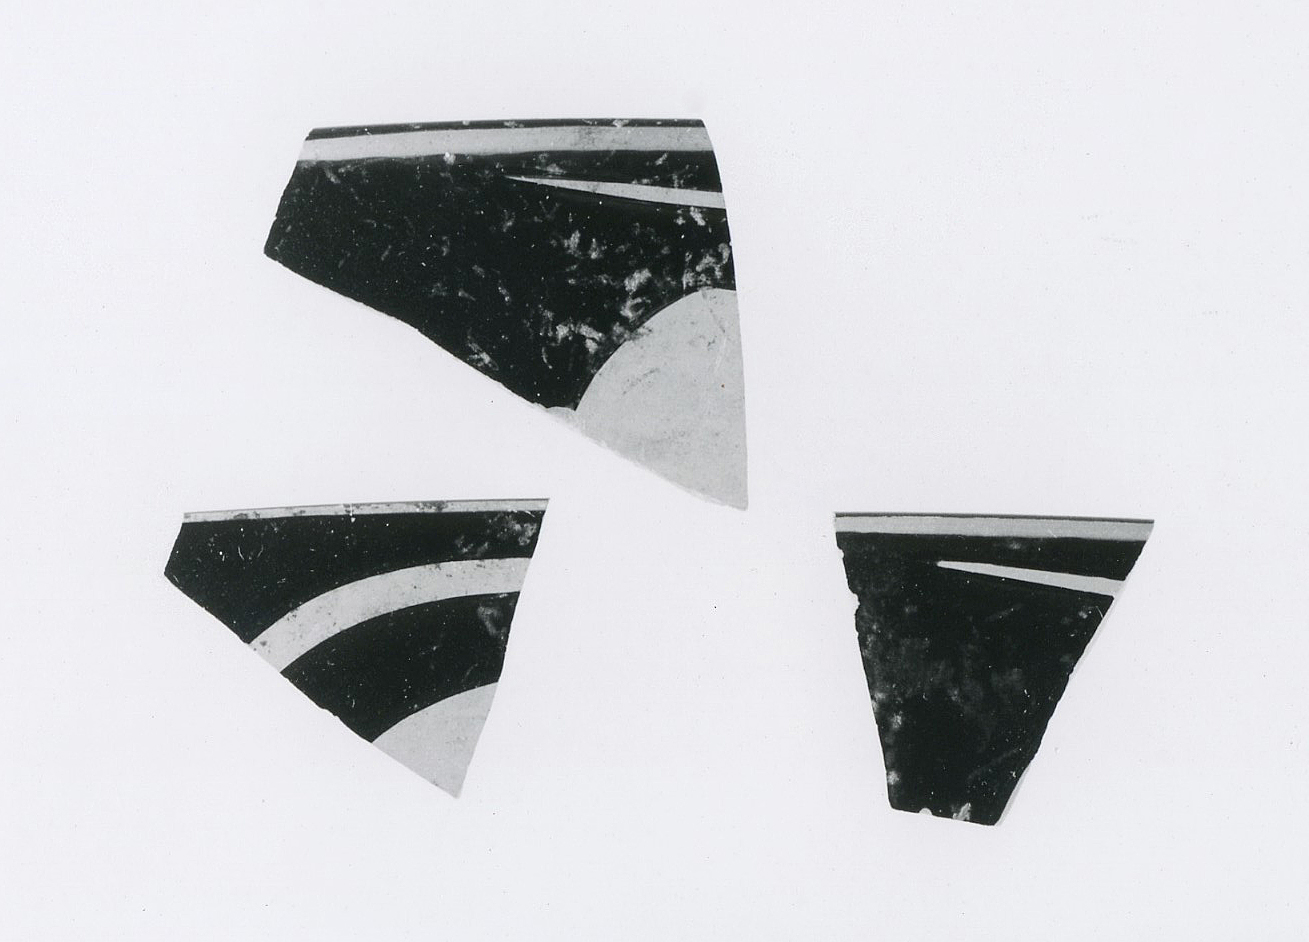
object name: kylix, eye cup fragment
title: Kylix, eye-cup fragments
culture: greek, attic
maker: epiktetos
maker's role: artist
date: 534-501 BCE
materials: terracotta